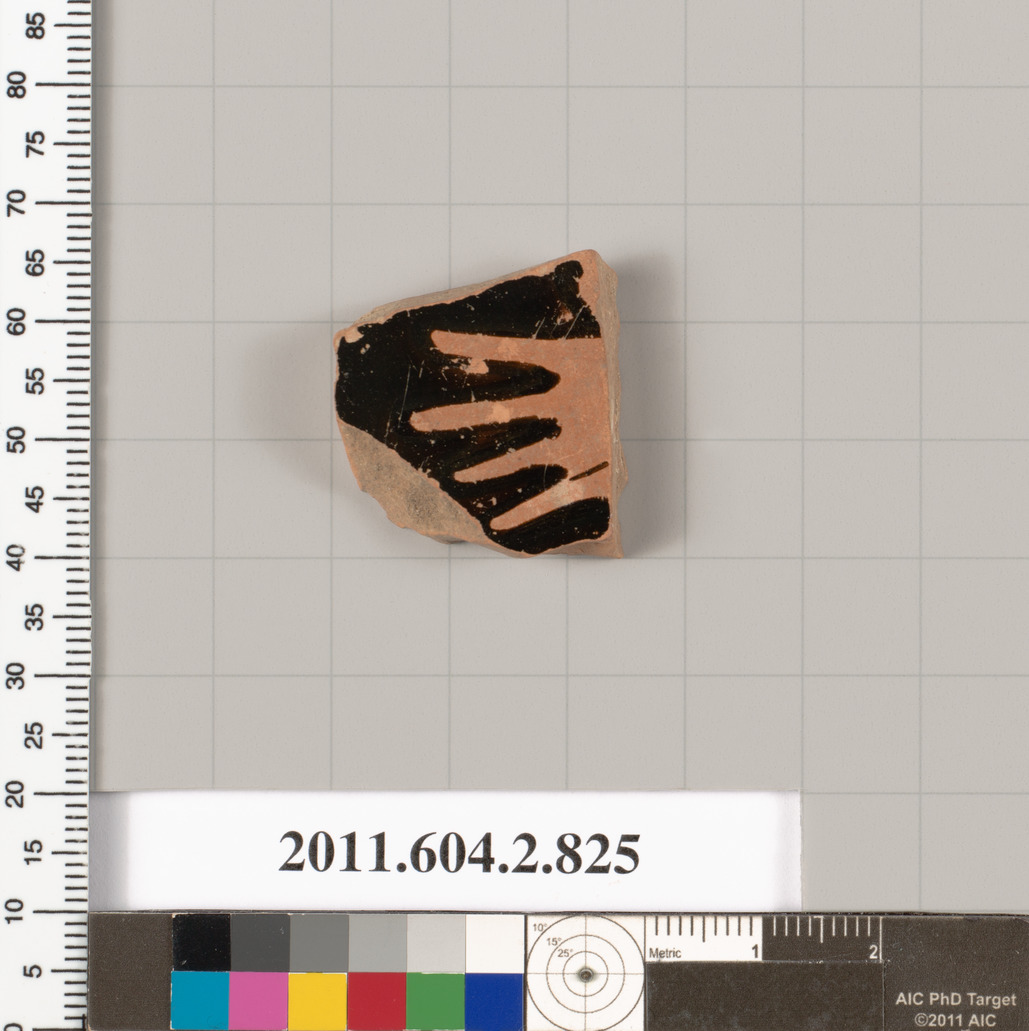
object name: bell krater fragment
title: Terracotta fragment of a bell-krater (bowl for mixing wine and water)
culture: greek, attic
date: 470-450 BCE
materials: terracotta